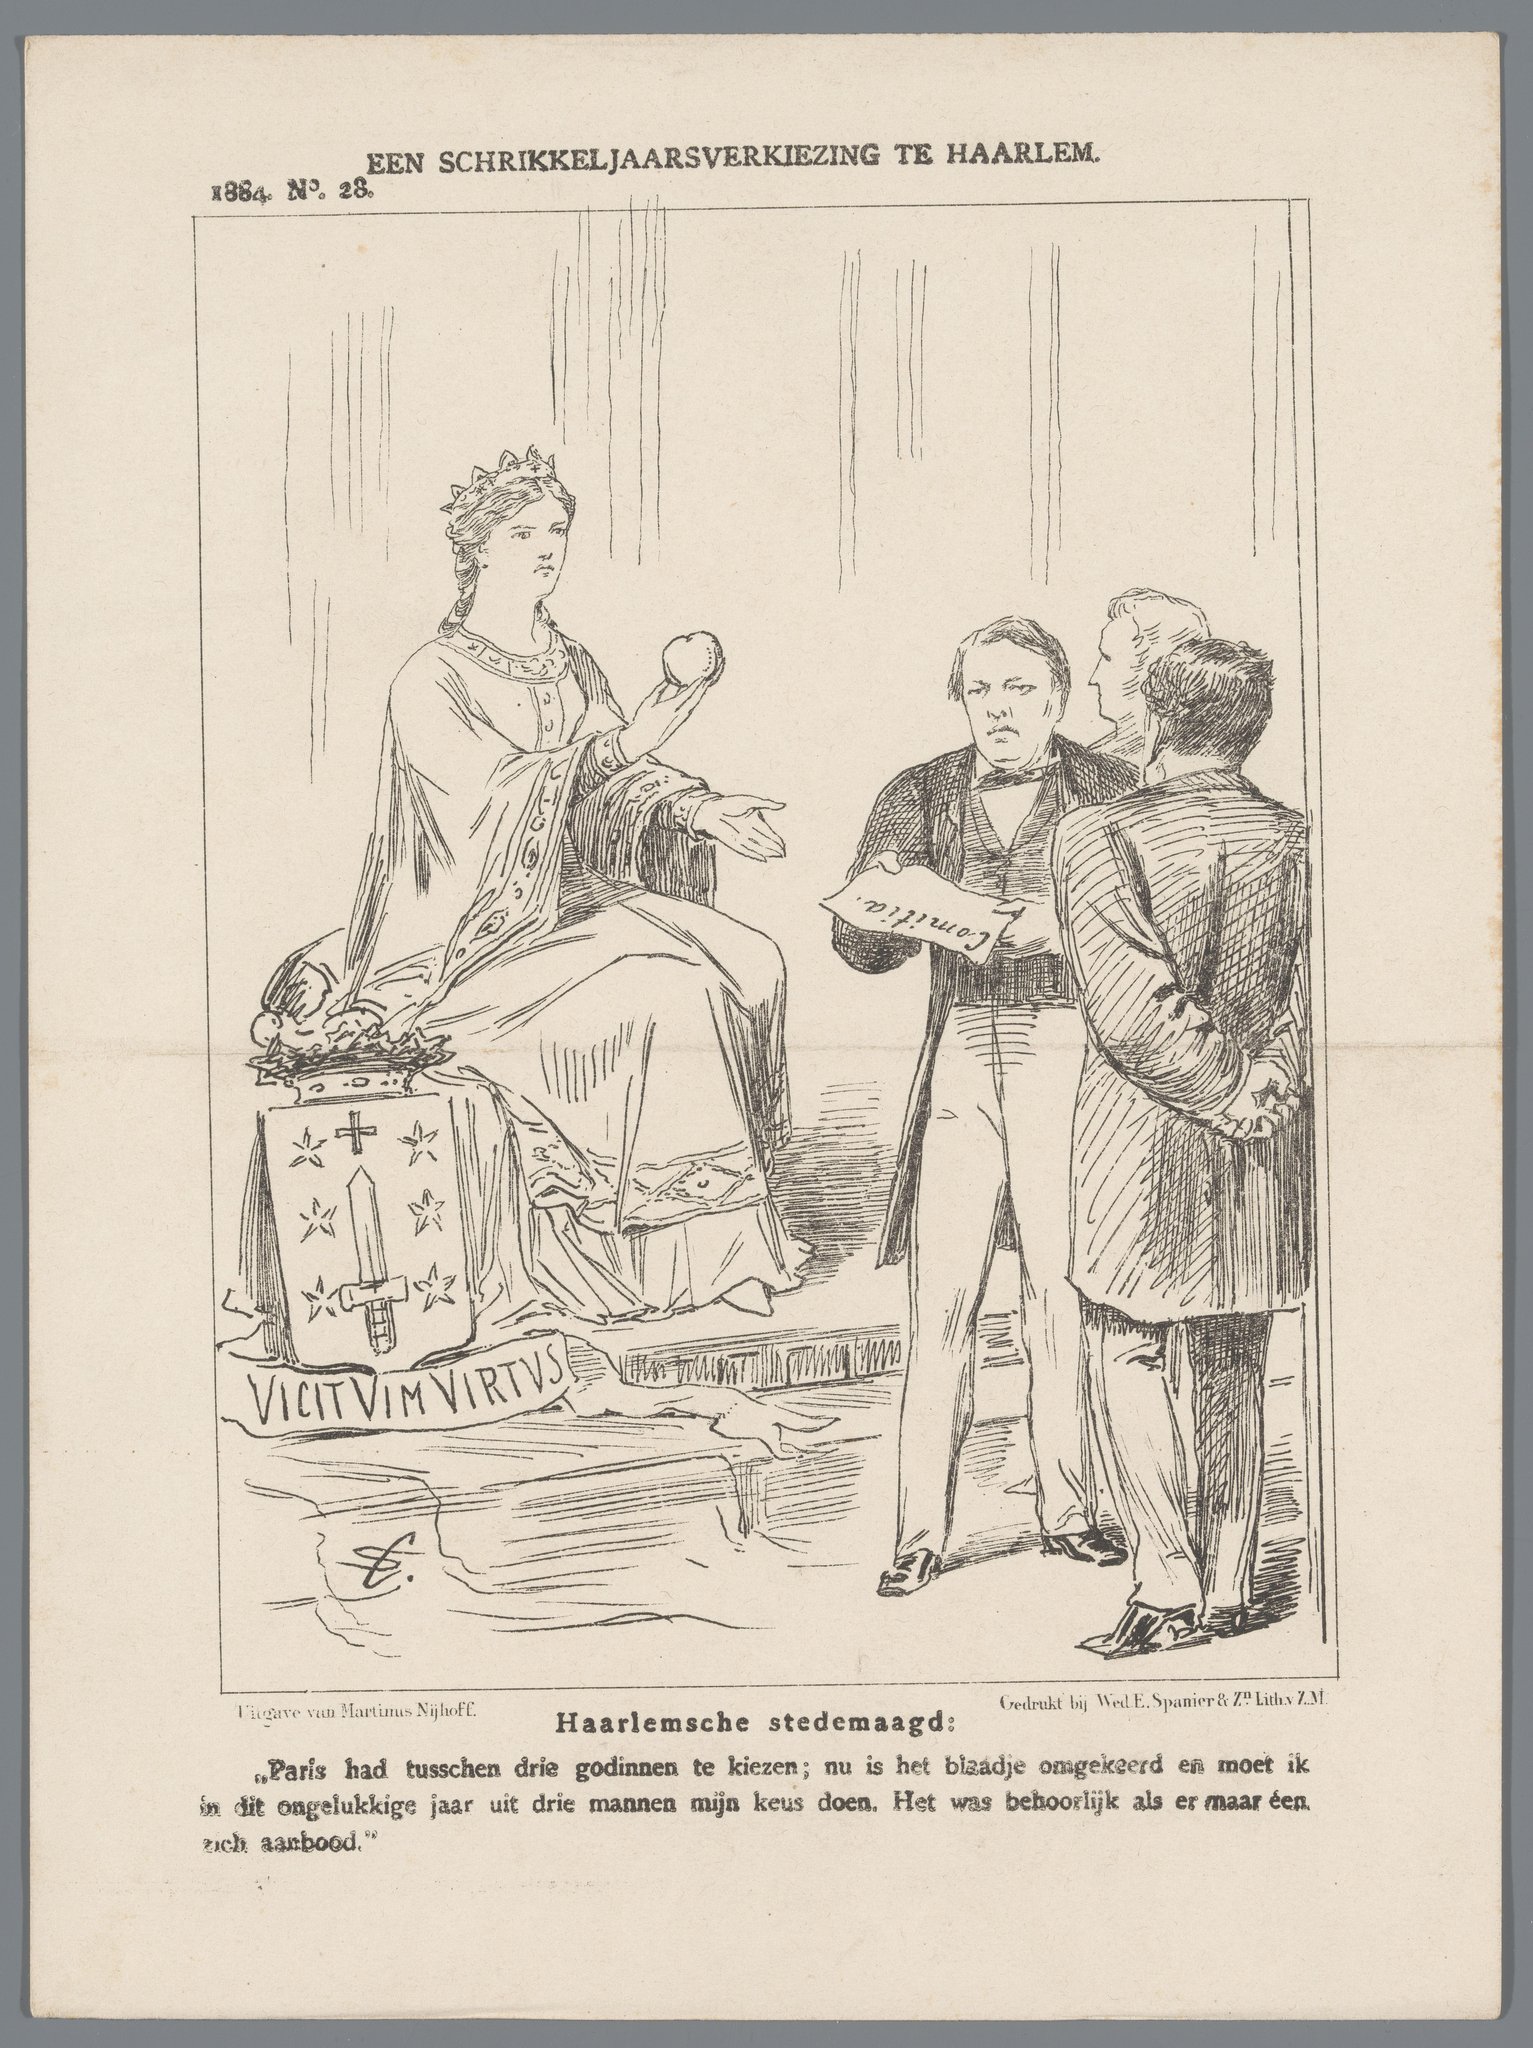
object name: cartoon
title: Spotprent op de verkiezingen te Haarlem, 1884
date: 1884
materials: paper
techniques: lithograph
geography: netherlands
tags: personification of a city, town-patron(ess), haarlem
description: Spotprent op de verkiezingen te Haarlem, 1884. Plaat verschenen bij het weekblad De Nederlandsche Spectator, nr. 28, 1884.